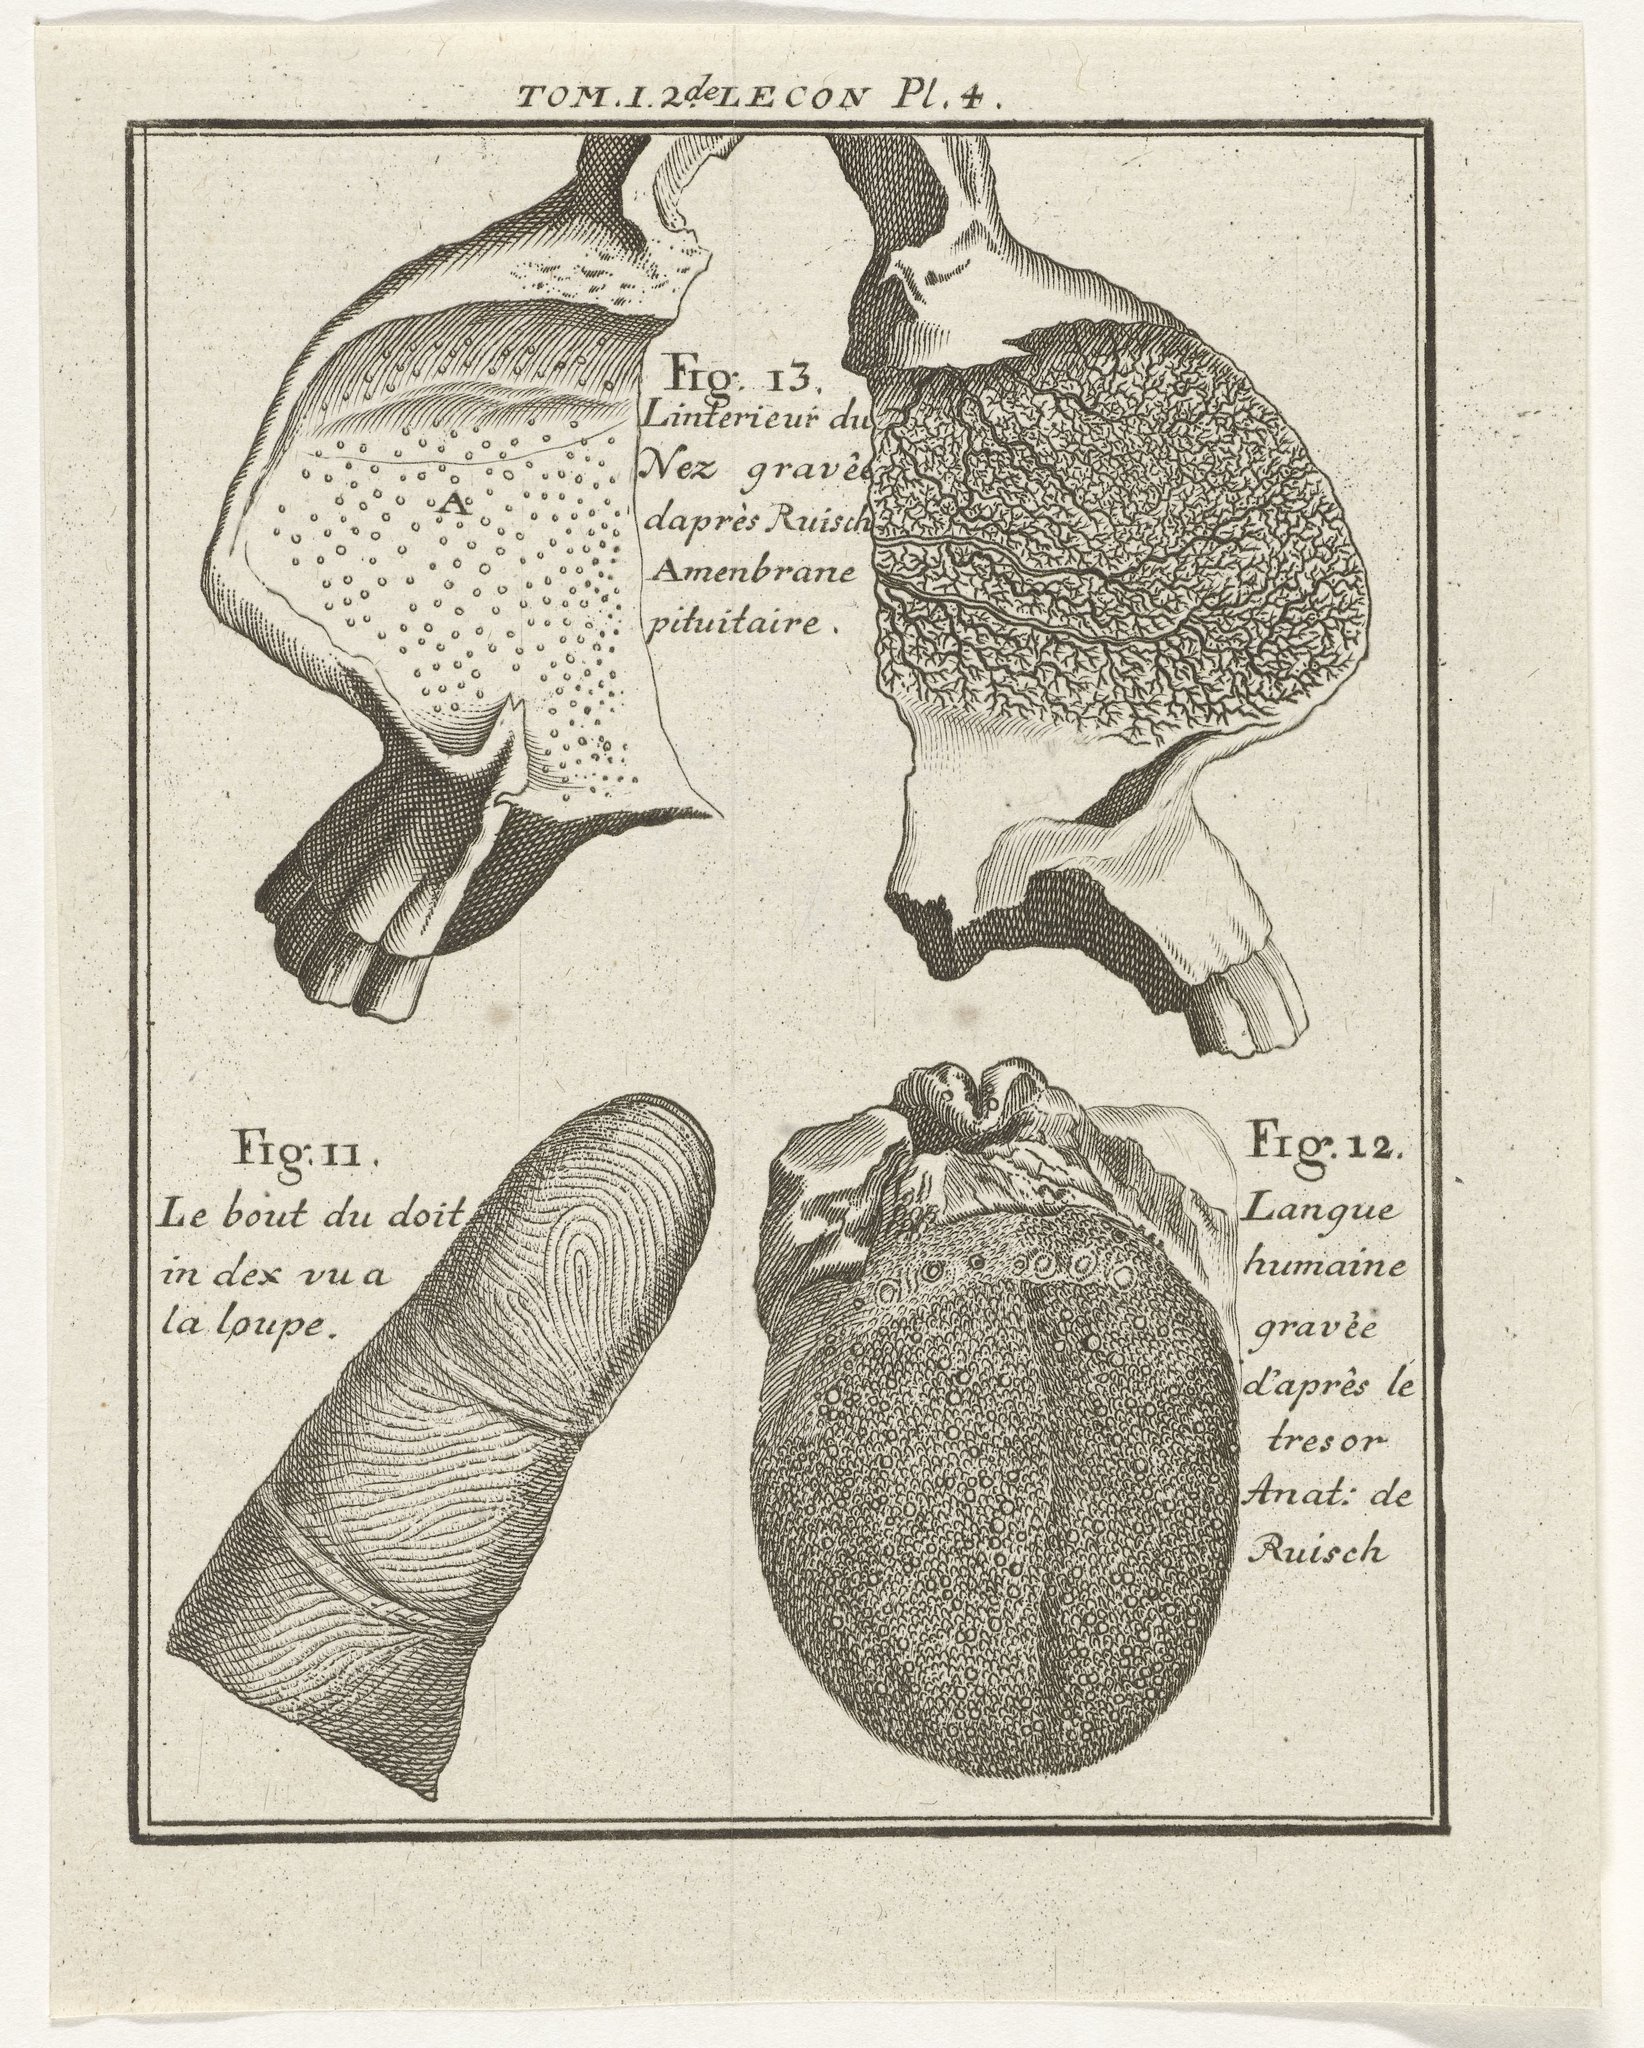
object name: print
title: Anatomische weergave van de tong, neus en wijsvinger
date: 1759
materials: paper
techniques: etching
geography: amsterdam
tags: anatomical models (usually series of five figures)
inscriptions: collector's mark: Lugt 2228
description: Anatomische weergave van de tong, binnenkant van de neus en de wijsvinger, voorzien van nummers. Prent middenboven gemerkt: Tom. I.2.de Lecon Pl. 4.